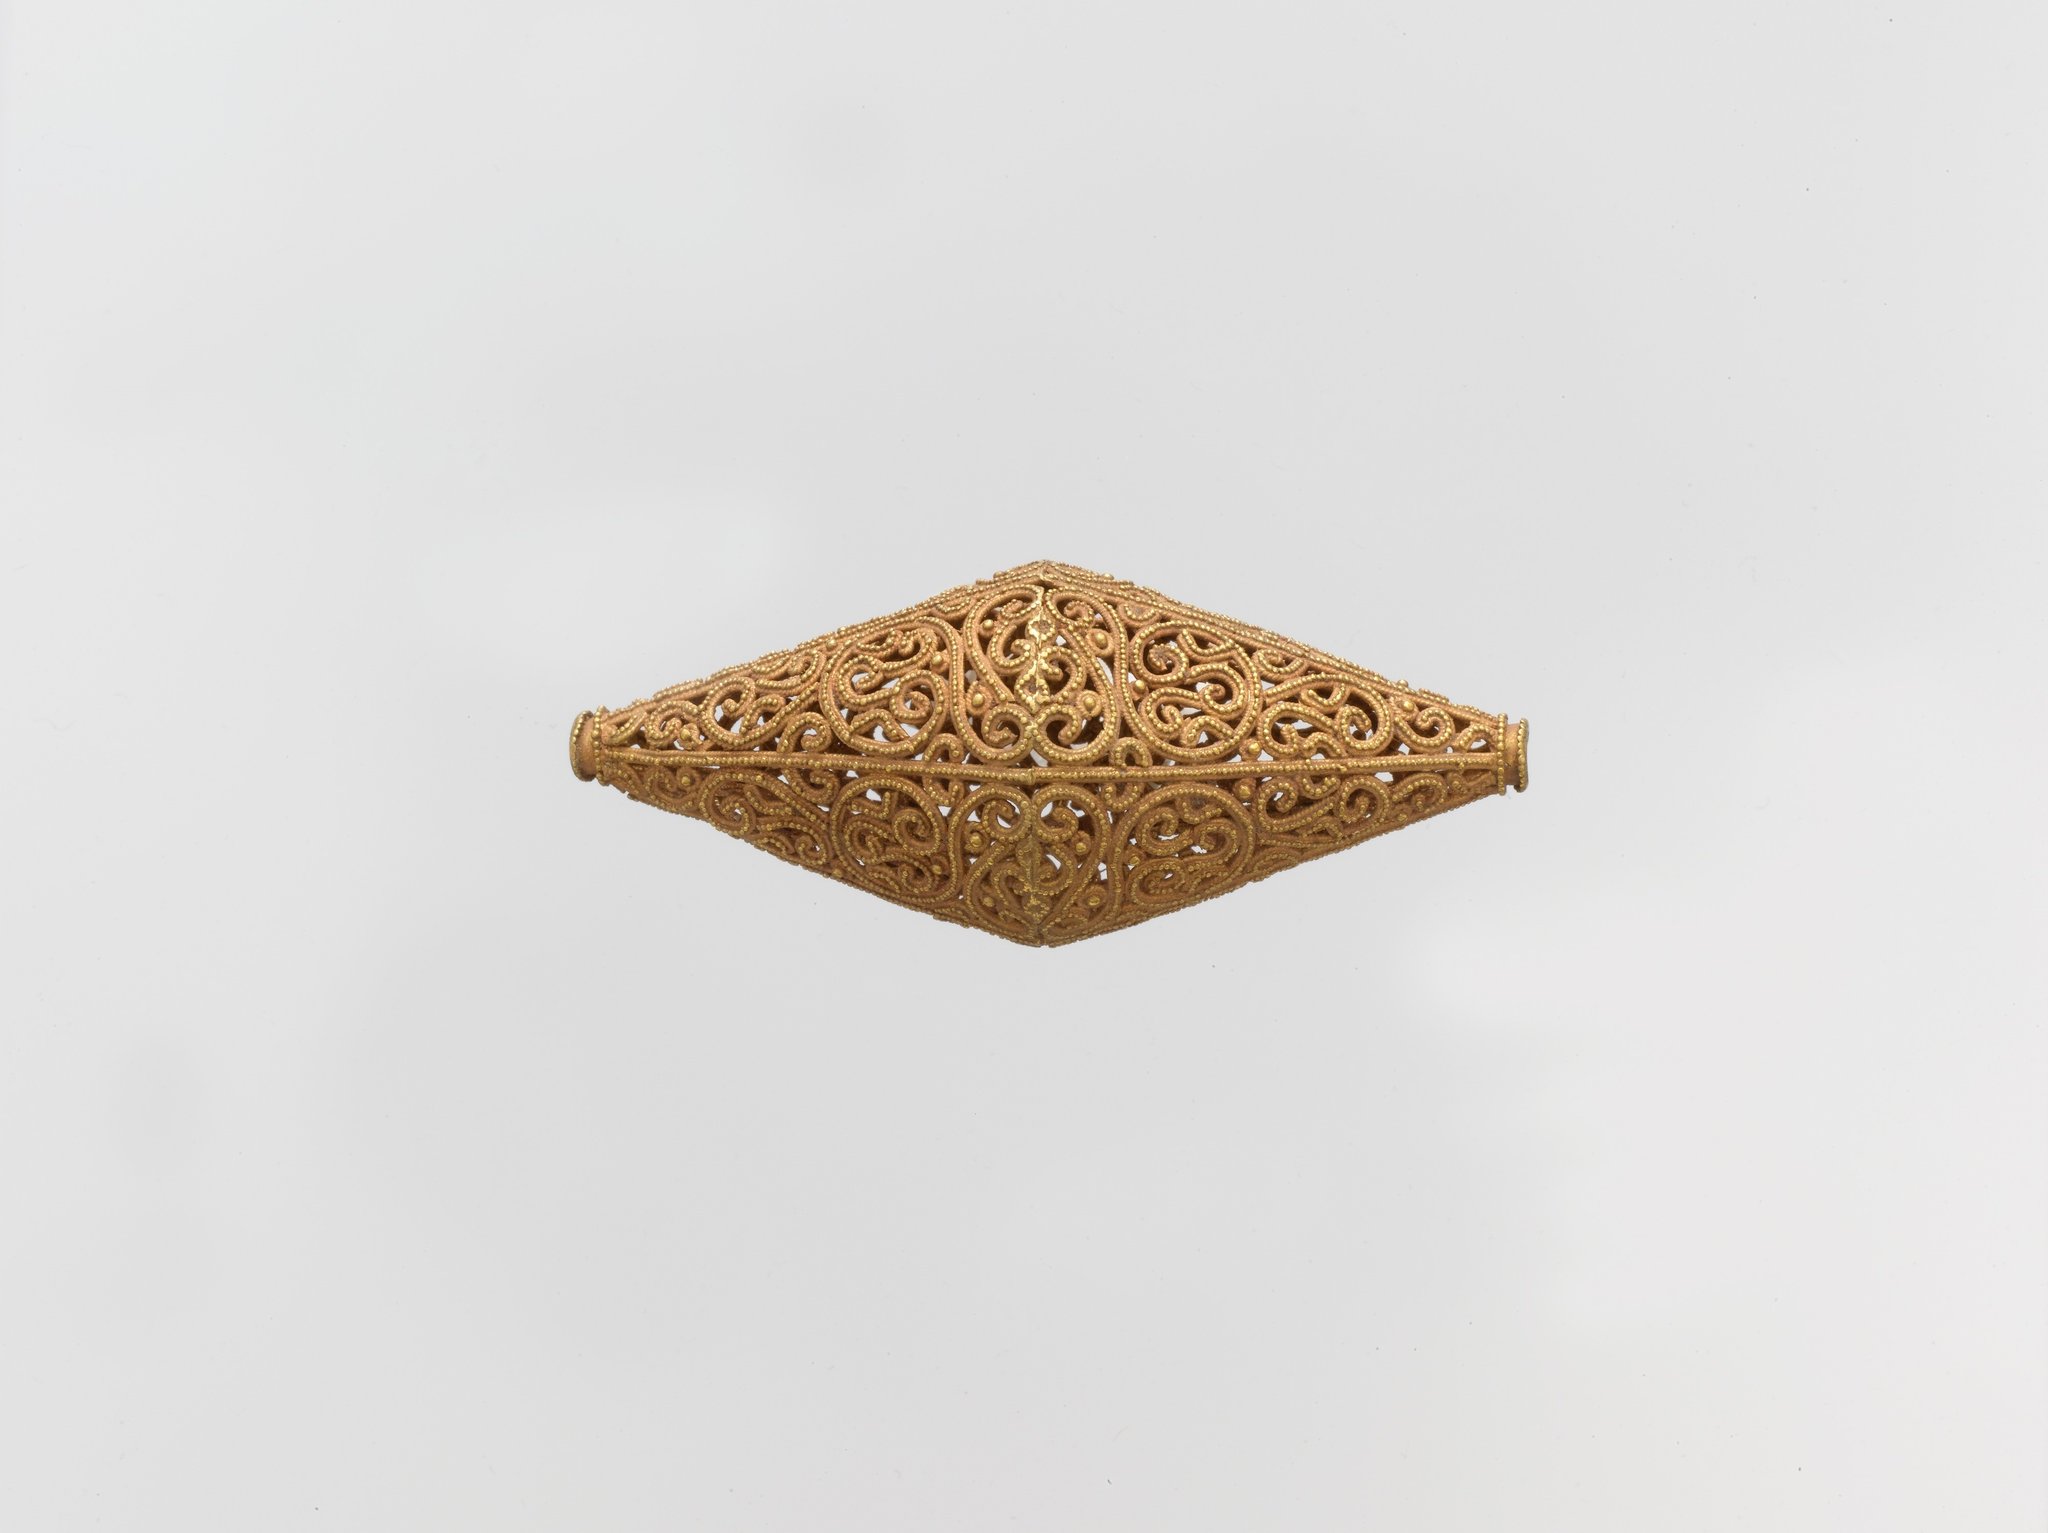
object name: bead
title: Biconical Bead with Scrolls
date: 1001-1100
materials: gold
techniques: filigree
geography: egypt or syria